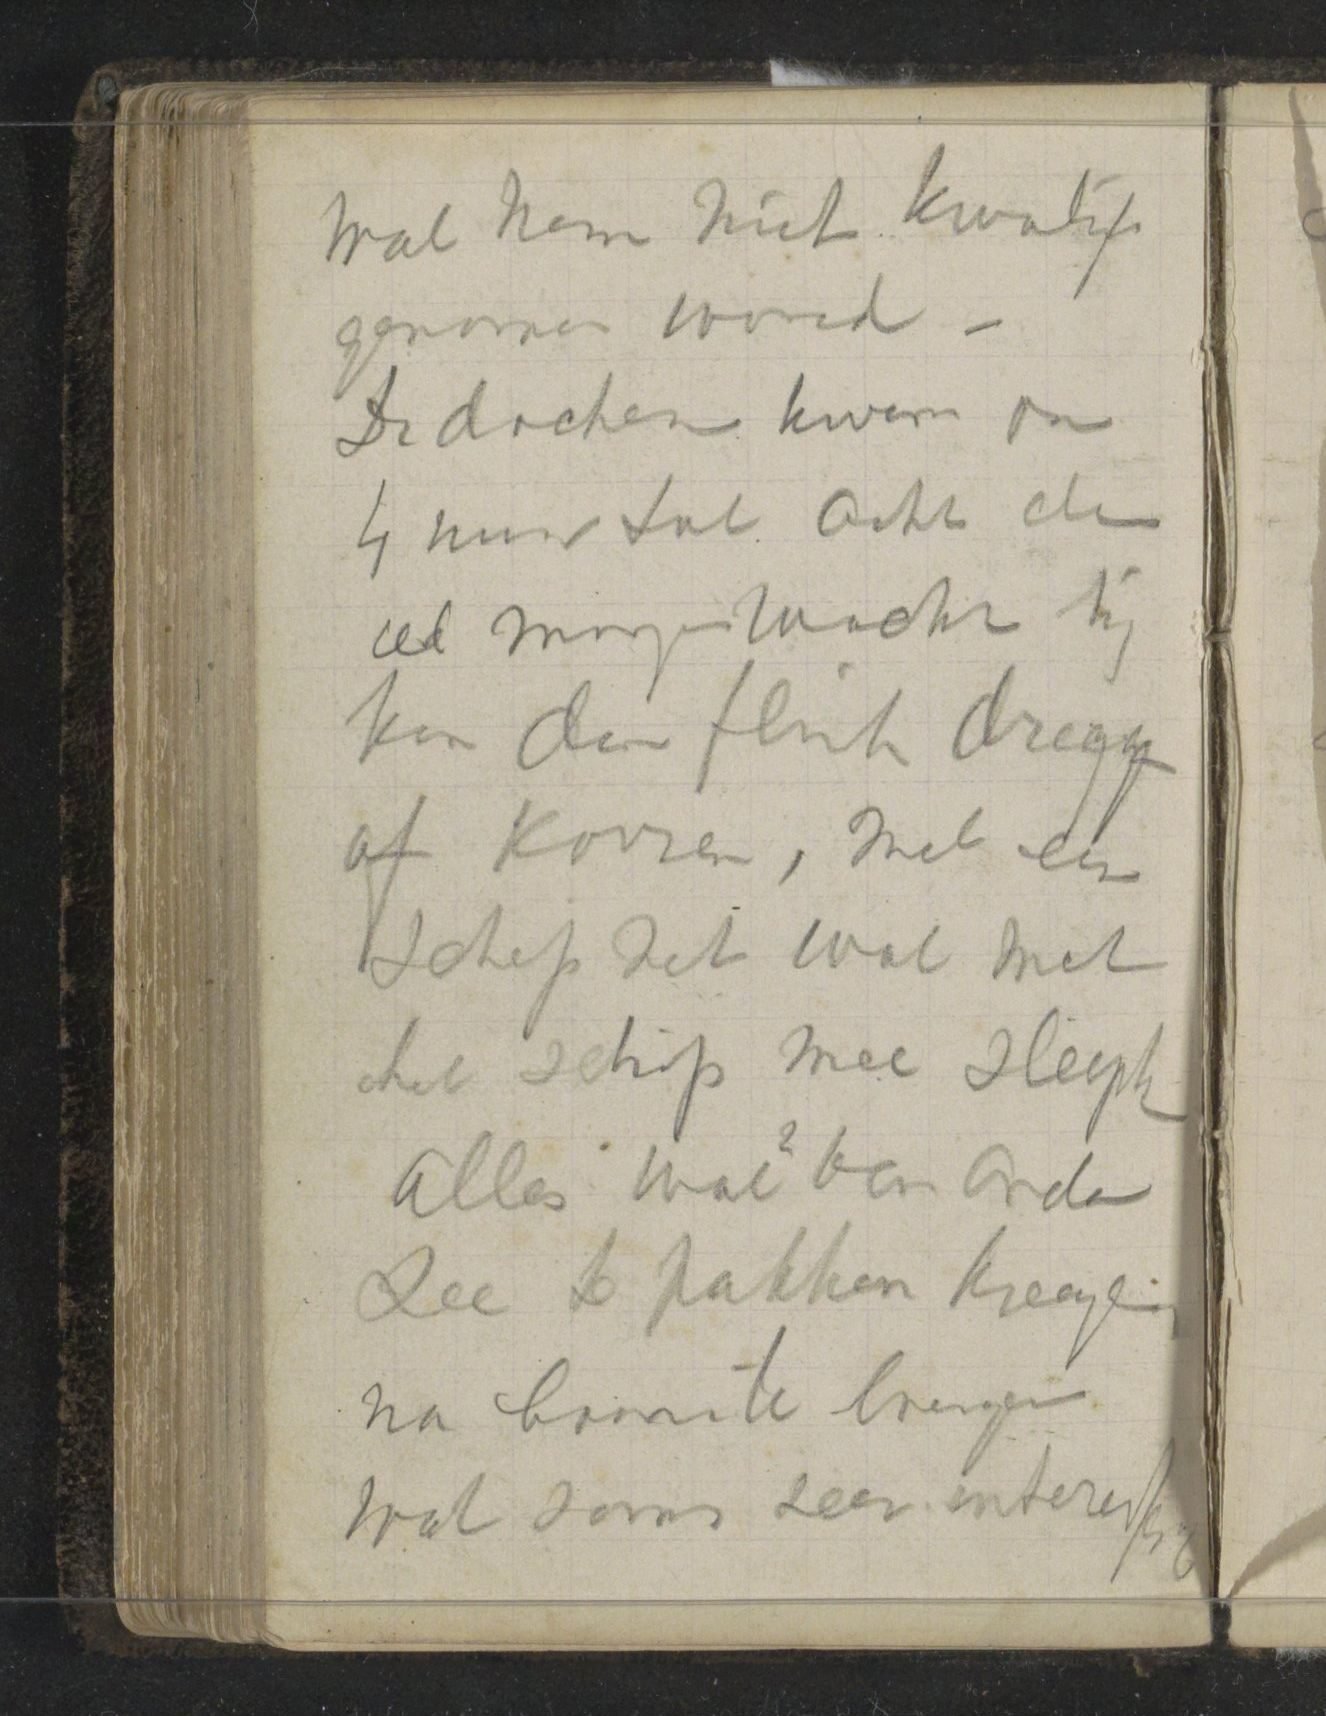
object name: sketchbook leaf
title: Reisverslag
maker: louis apol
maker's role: draughtsman, painter, print maker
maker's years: 1850-1936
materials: pencil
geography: novaya zemlya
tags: nova zembla expedities 1880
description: Blad 87 verso uit een schetsboek met 110 bladen betekend tijdens de expeditie naar Nova Zembla in 1880.